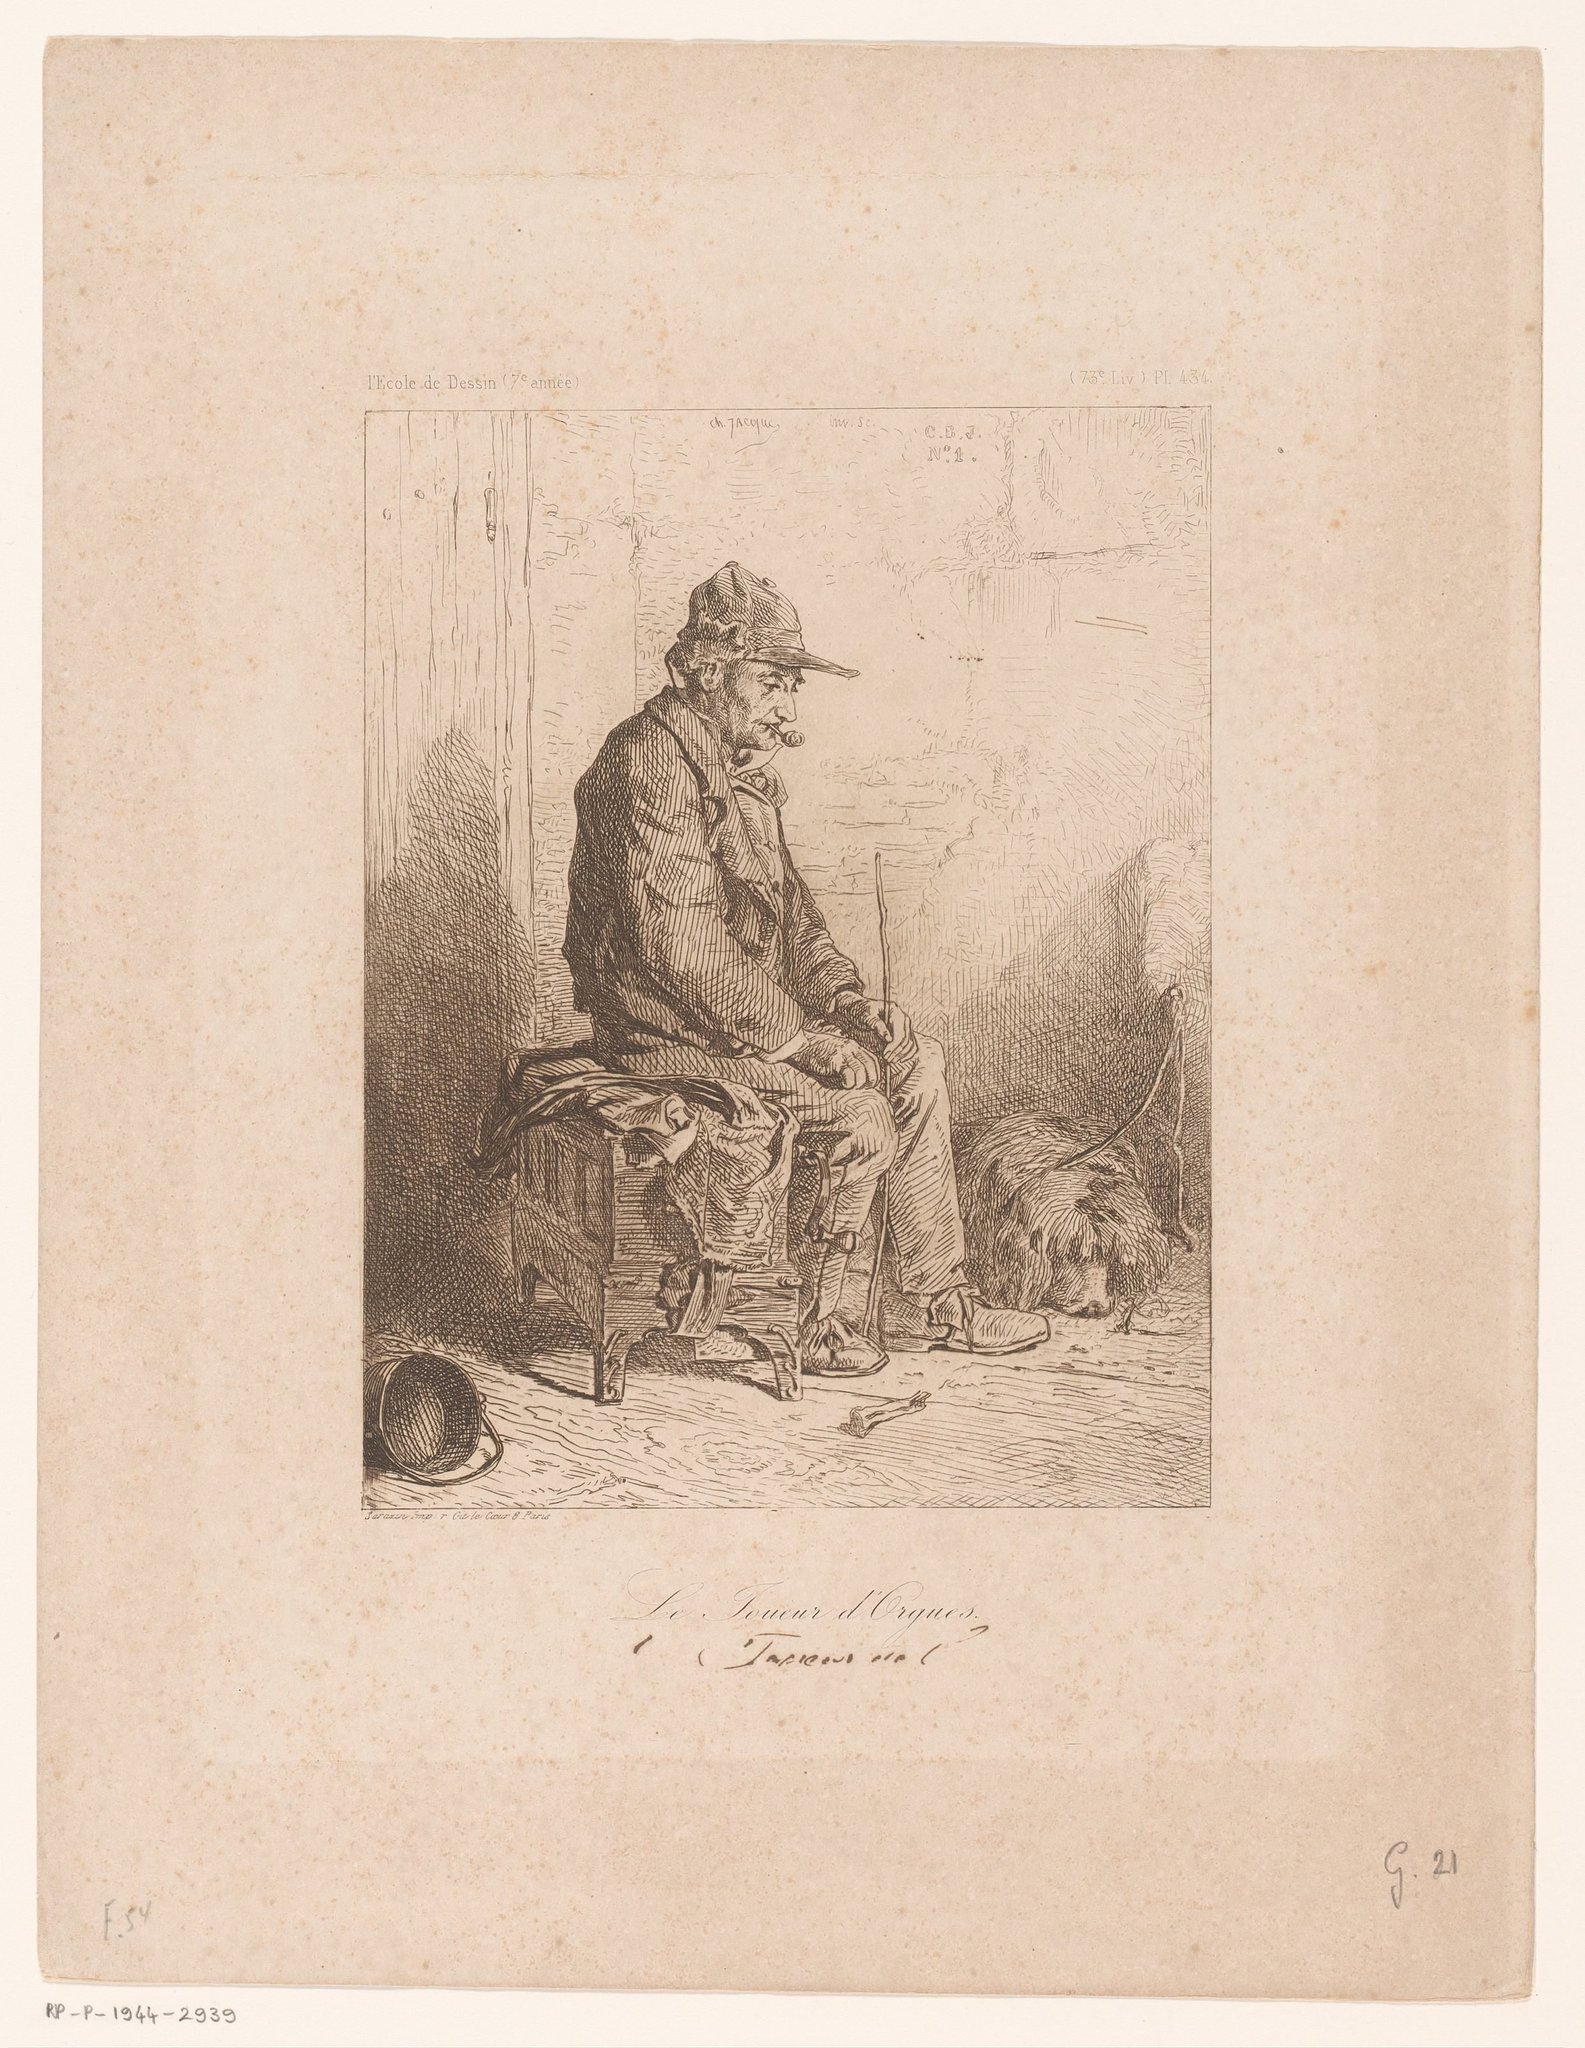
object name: print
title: Le Joueur d'Orgues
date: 1844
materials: paper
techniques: etching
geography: paris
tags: pipe ~ tobacco, hurdy-gurdy player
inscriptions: collector's mark: Lugt 2228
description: Gepubliceerd in 'l'Ecole de Dessin', jaargang 7, boek 73, plaat 434.